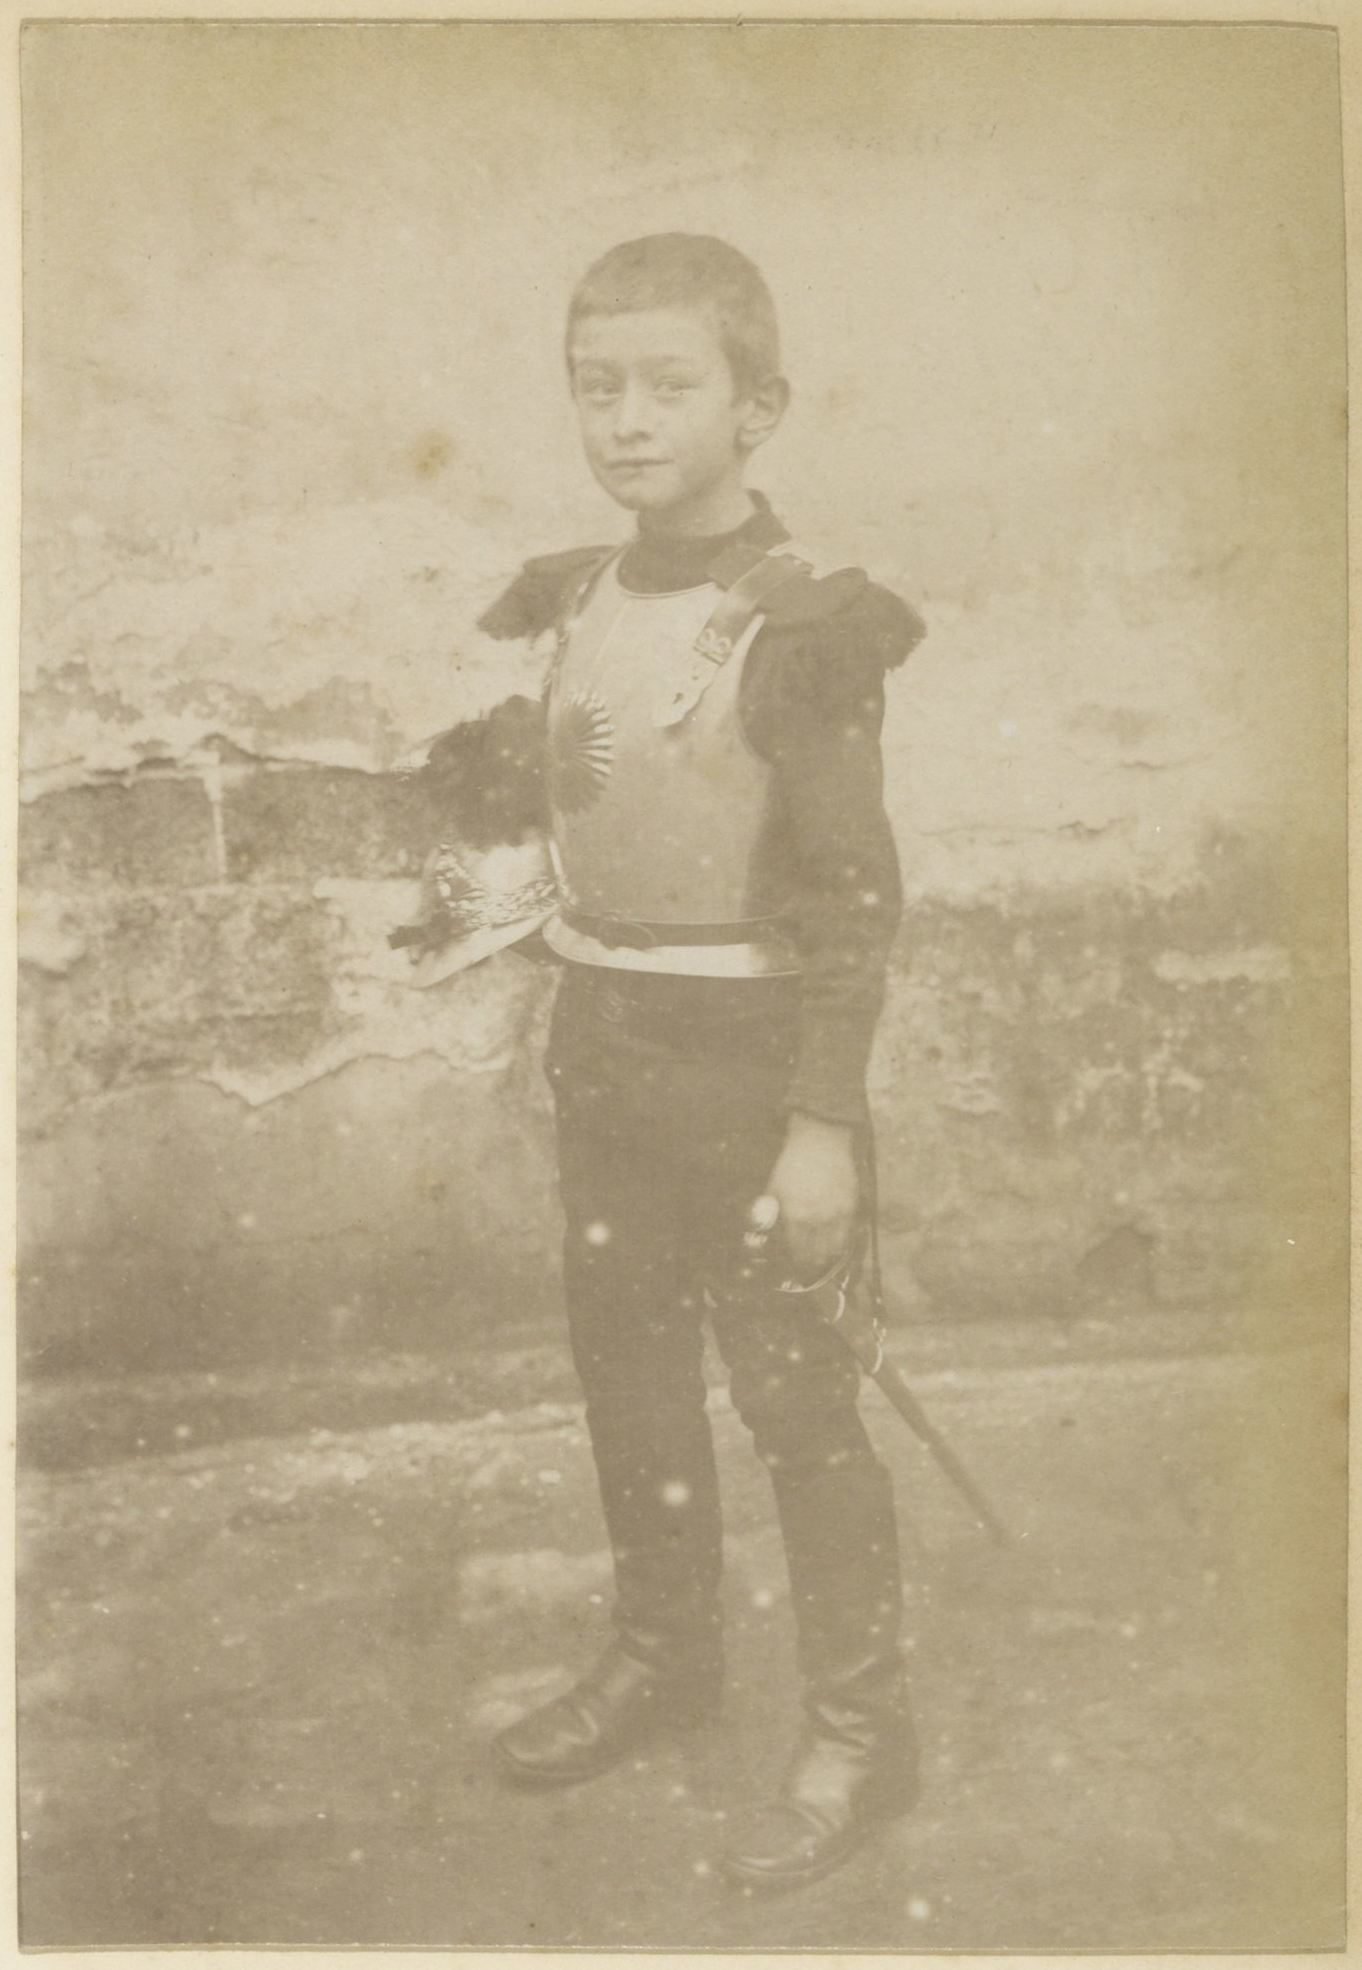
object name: photograph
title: Portret van een Franse jongen in harnas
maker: Anonymous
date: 1900-1910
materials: paper, photographic support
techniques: albumen print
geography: france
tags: children's games and plays, armour, child, (military) uniforms, france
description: Onderdeel van Fotoalbum van een Franse amateurfotograaf met opnames van een familie, distilleerderij Delizy & Doistau Fils, het leger en bezienswaardigheden in Frankrijk.